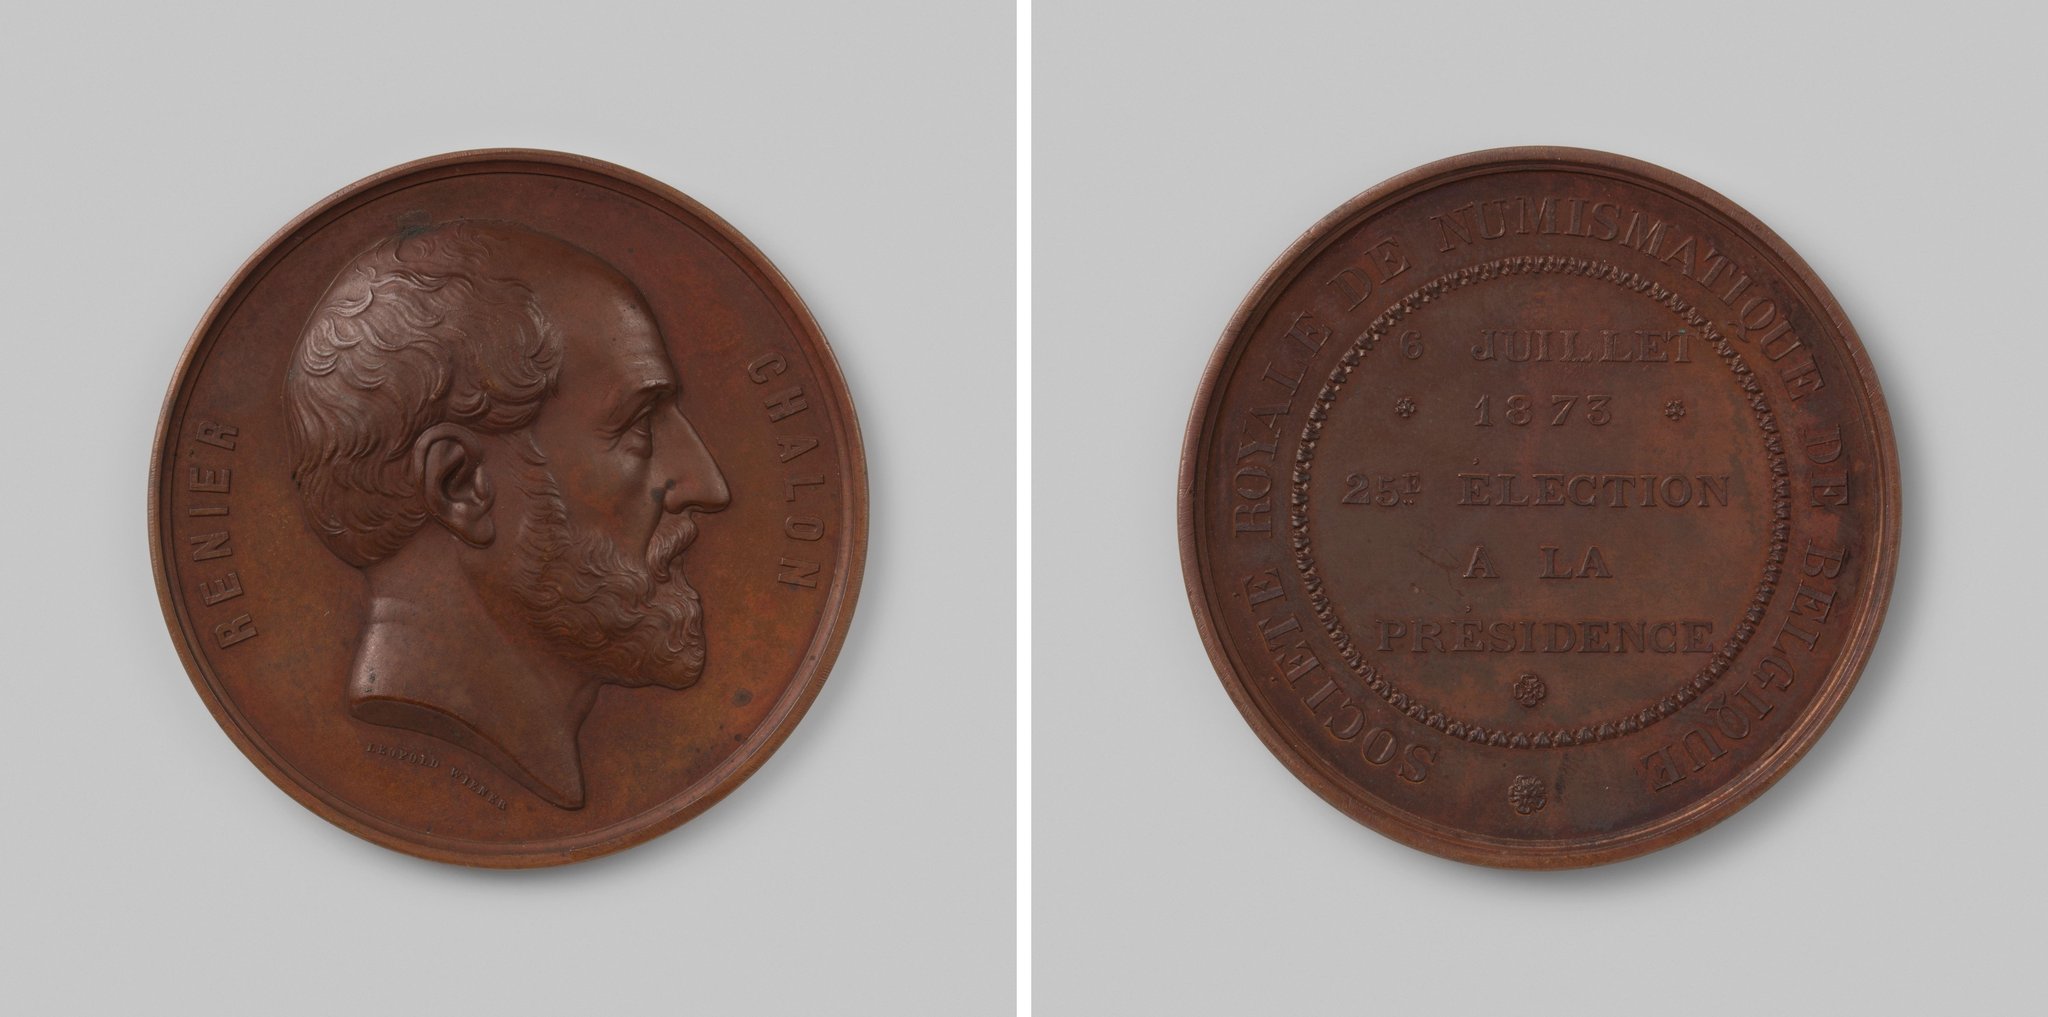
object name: honorary medal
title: Renier Chalon, voor de vijfentwintigste maal tot voorzitter van de Societe Royale de Numismatique de Belgique gekozen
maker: leopold wiener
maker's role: sculptor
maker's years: 1823-1891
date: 1873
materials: bronze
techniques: striking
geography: brussels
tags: brussels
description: Bronzen penning. Voorzijde: borststuk man binnen omschrift. Keerzijde: opschrift binnen omschrift